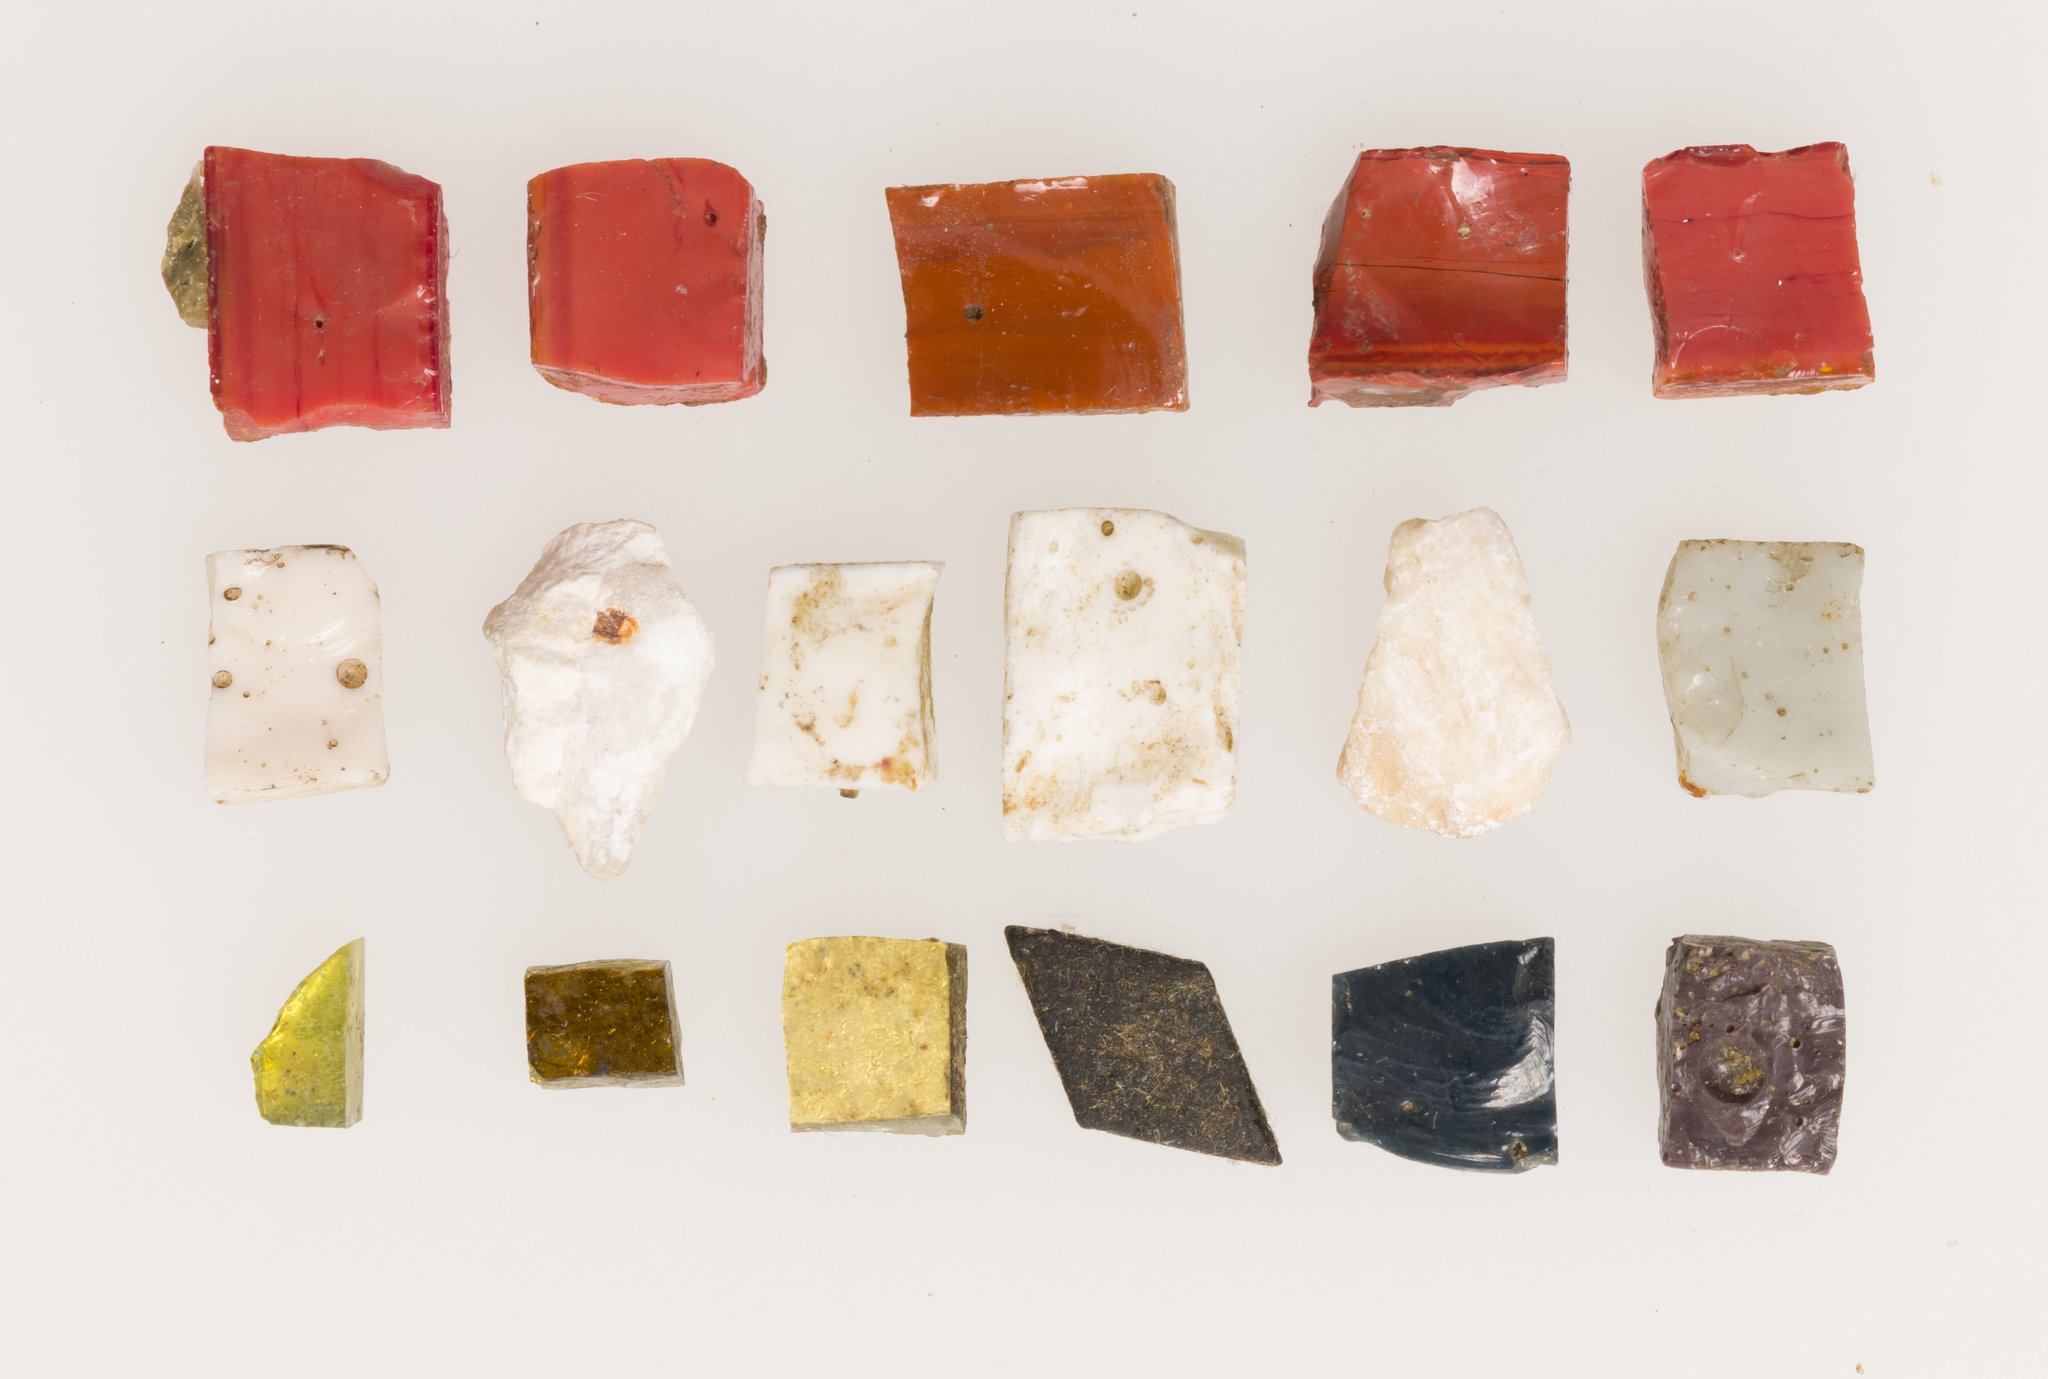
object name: tessera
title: Mosaic Tesserae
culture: byzantine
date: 501-1500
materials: glass, gold leaf, stone